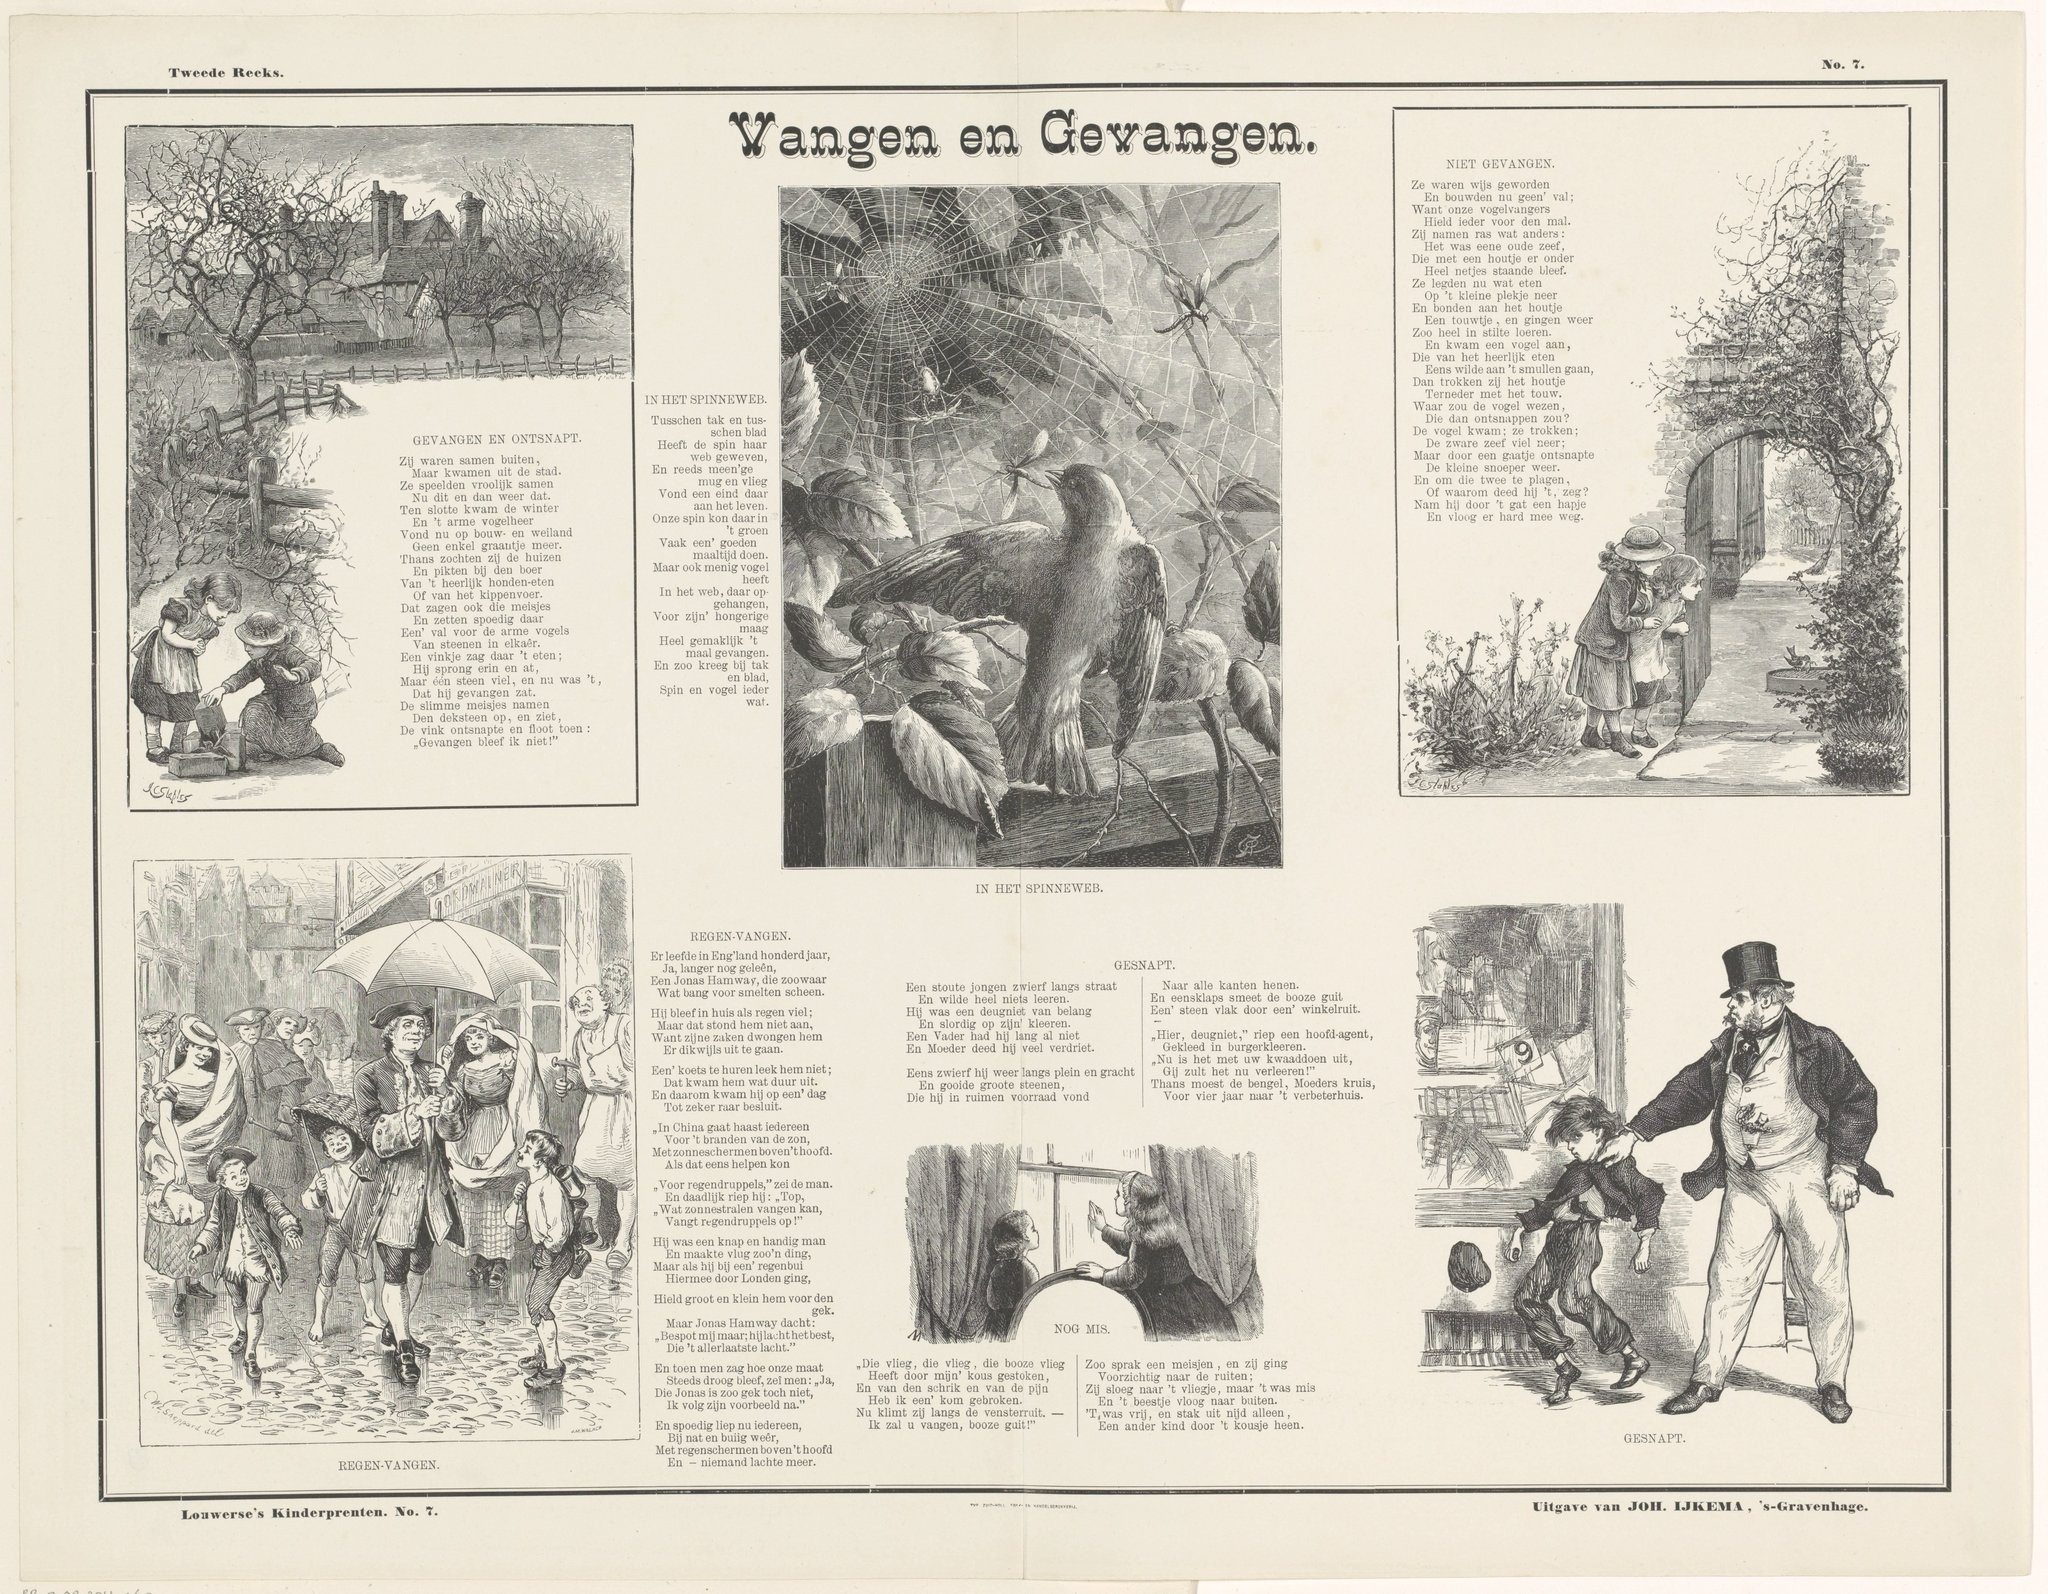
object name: popular print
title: Vangen en gevangen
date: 1887-1905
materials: paper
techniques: letterpress printing, printing block, engraving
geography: the hague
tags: rain, umbrella, animals (+ animals eating and drinking), child teasing animals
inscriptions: collector's mark: Lugt 2760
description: Blad met 6 voorstellingen van mensen en dieren die iets proberen te vangen. In en tussen de afbeeldingen versjes in boekdruk. Genummerd rechtsboven en linksonder: No. 7.